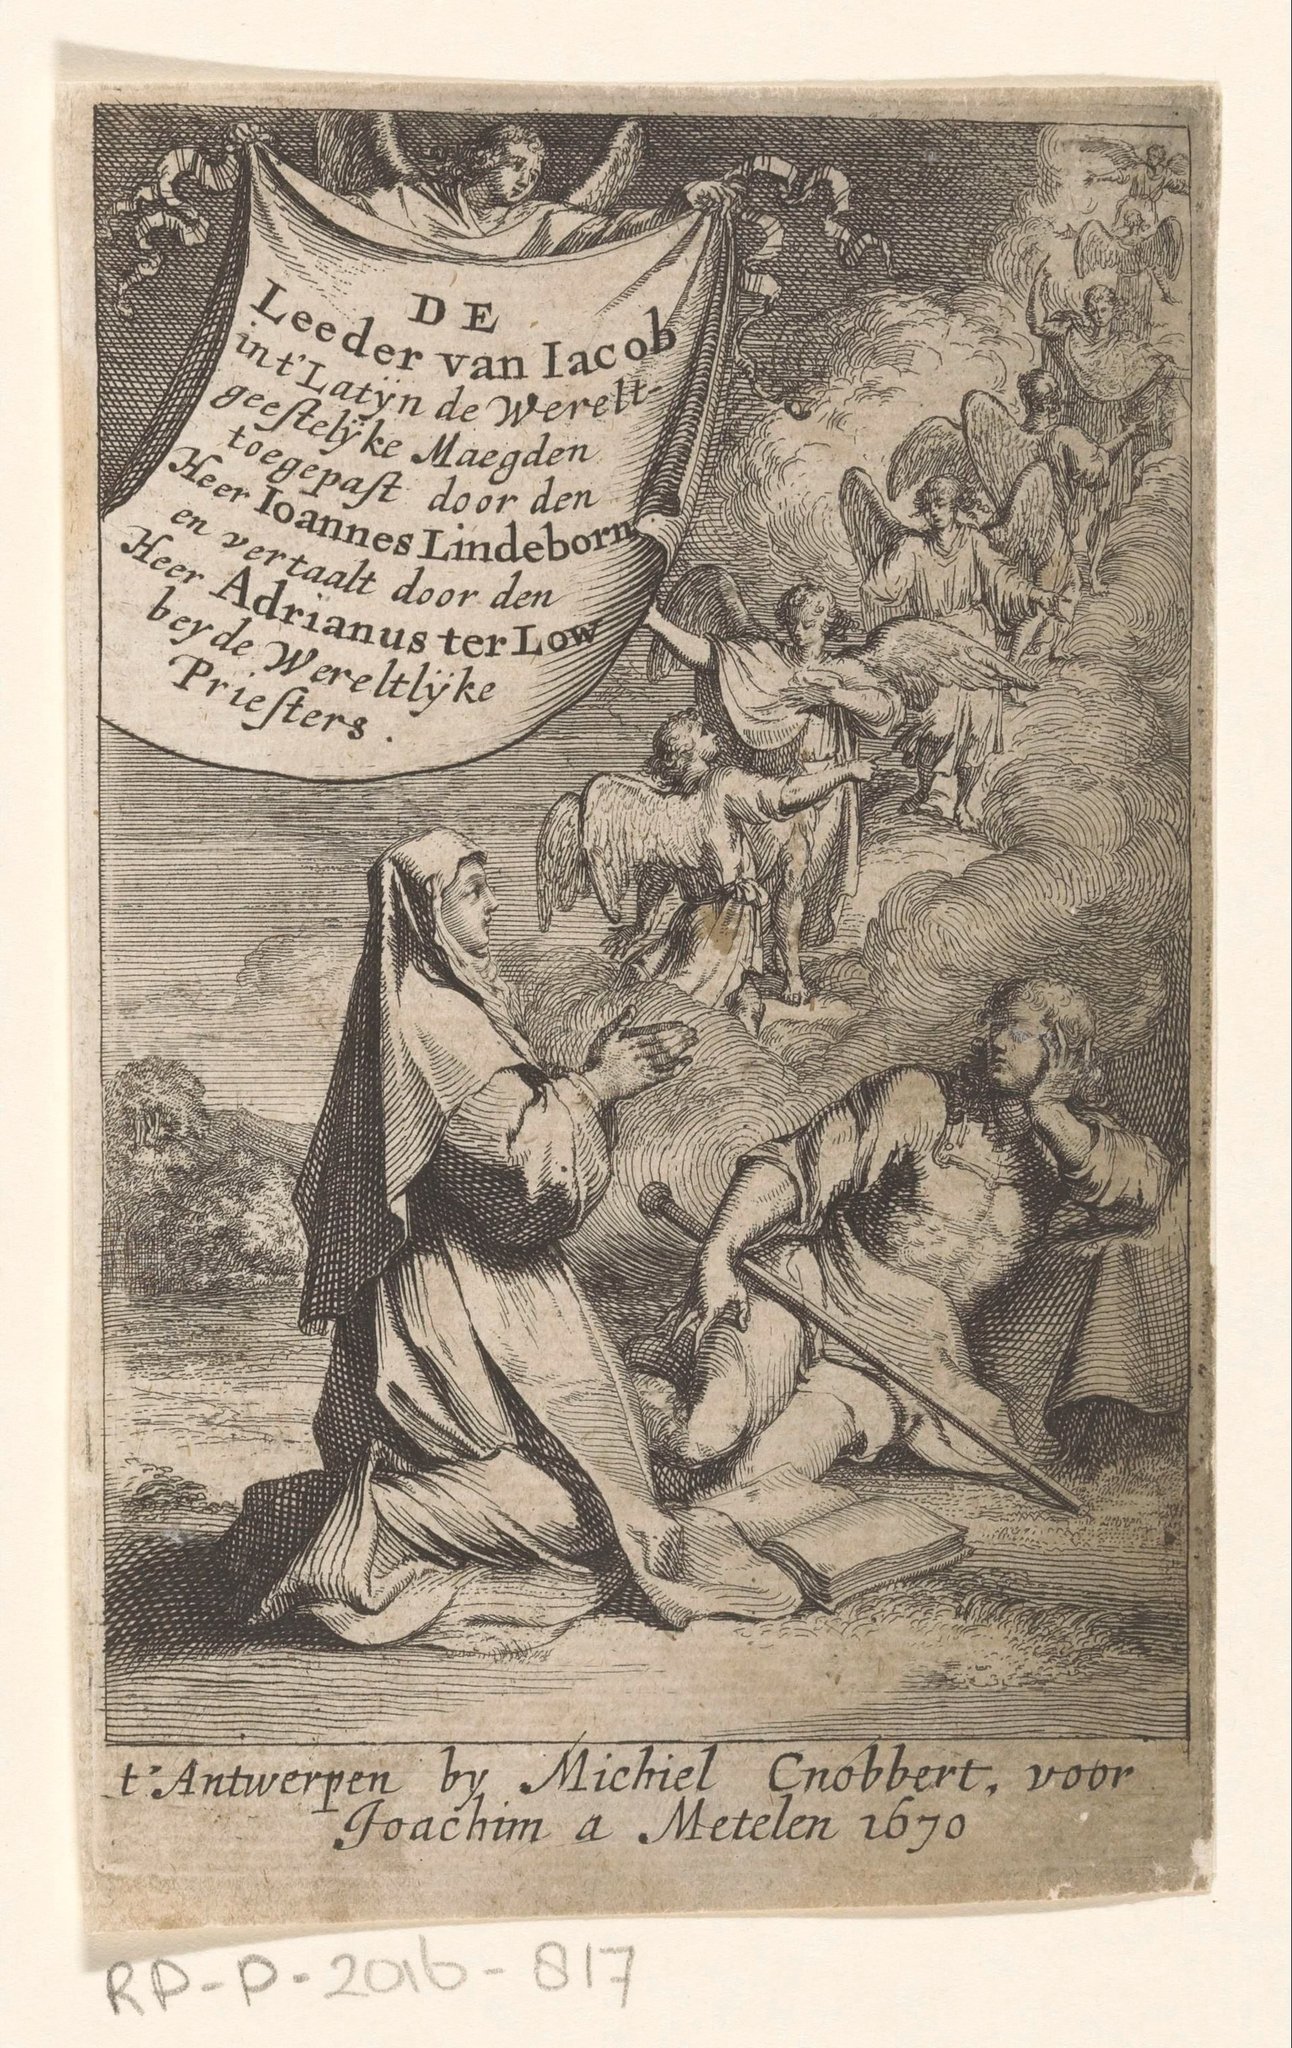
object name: titelblad, titelpagina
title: Jakobs ladder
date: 1670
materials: paper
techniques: etching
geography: antwerp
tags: the dream of jacob: while sleeping on the ground with a stone for pillow jacob sees a ladder reaching from earth to heaven with angels going up and down; usually with god at the top of the ladder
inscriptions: collector's mark: Lugt 2228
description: Jakob ligt tegen een steen te slapen en droomt van een ladder die naar de hemel reikt. Engelen klimmen de ladder op en af. Links zit een knielende vrouw. Links boven houdt een engel een doek met de titel van het boek vast.